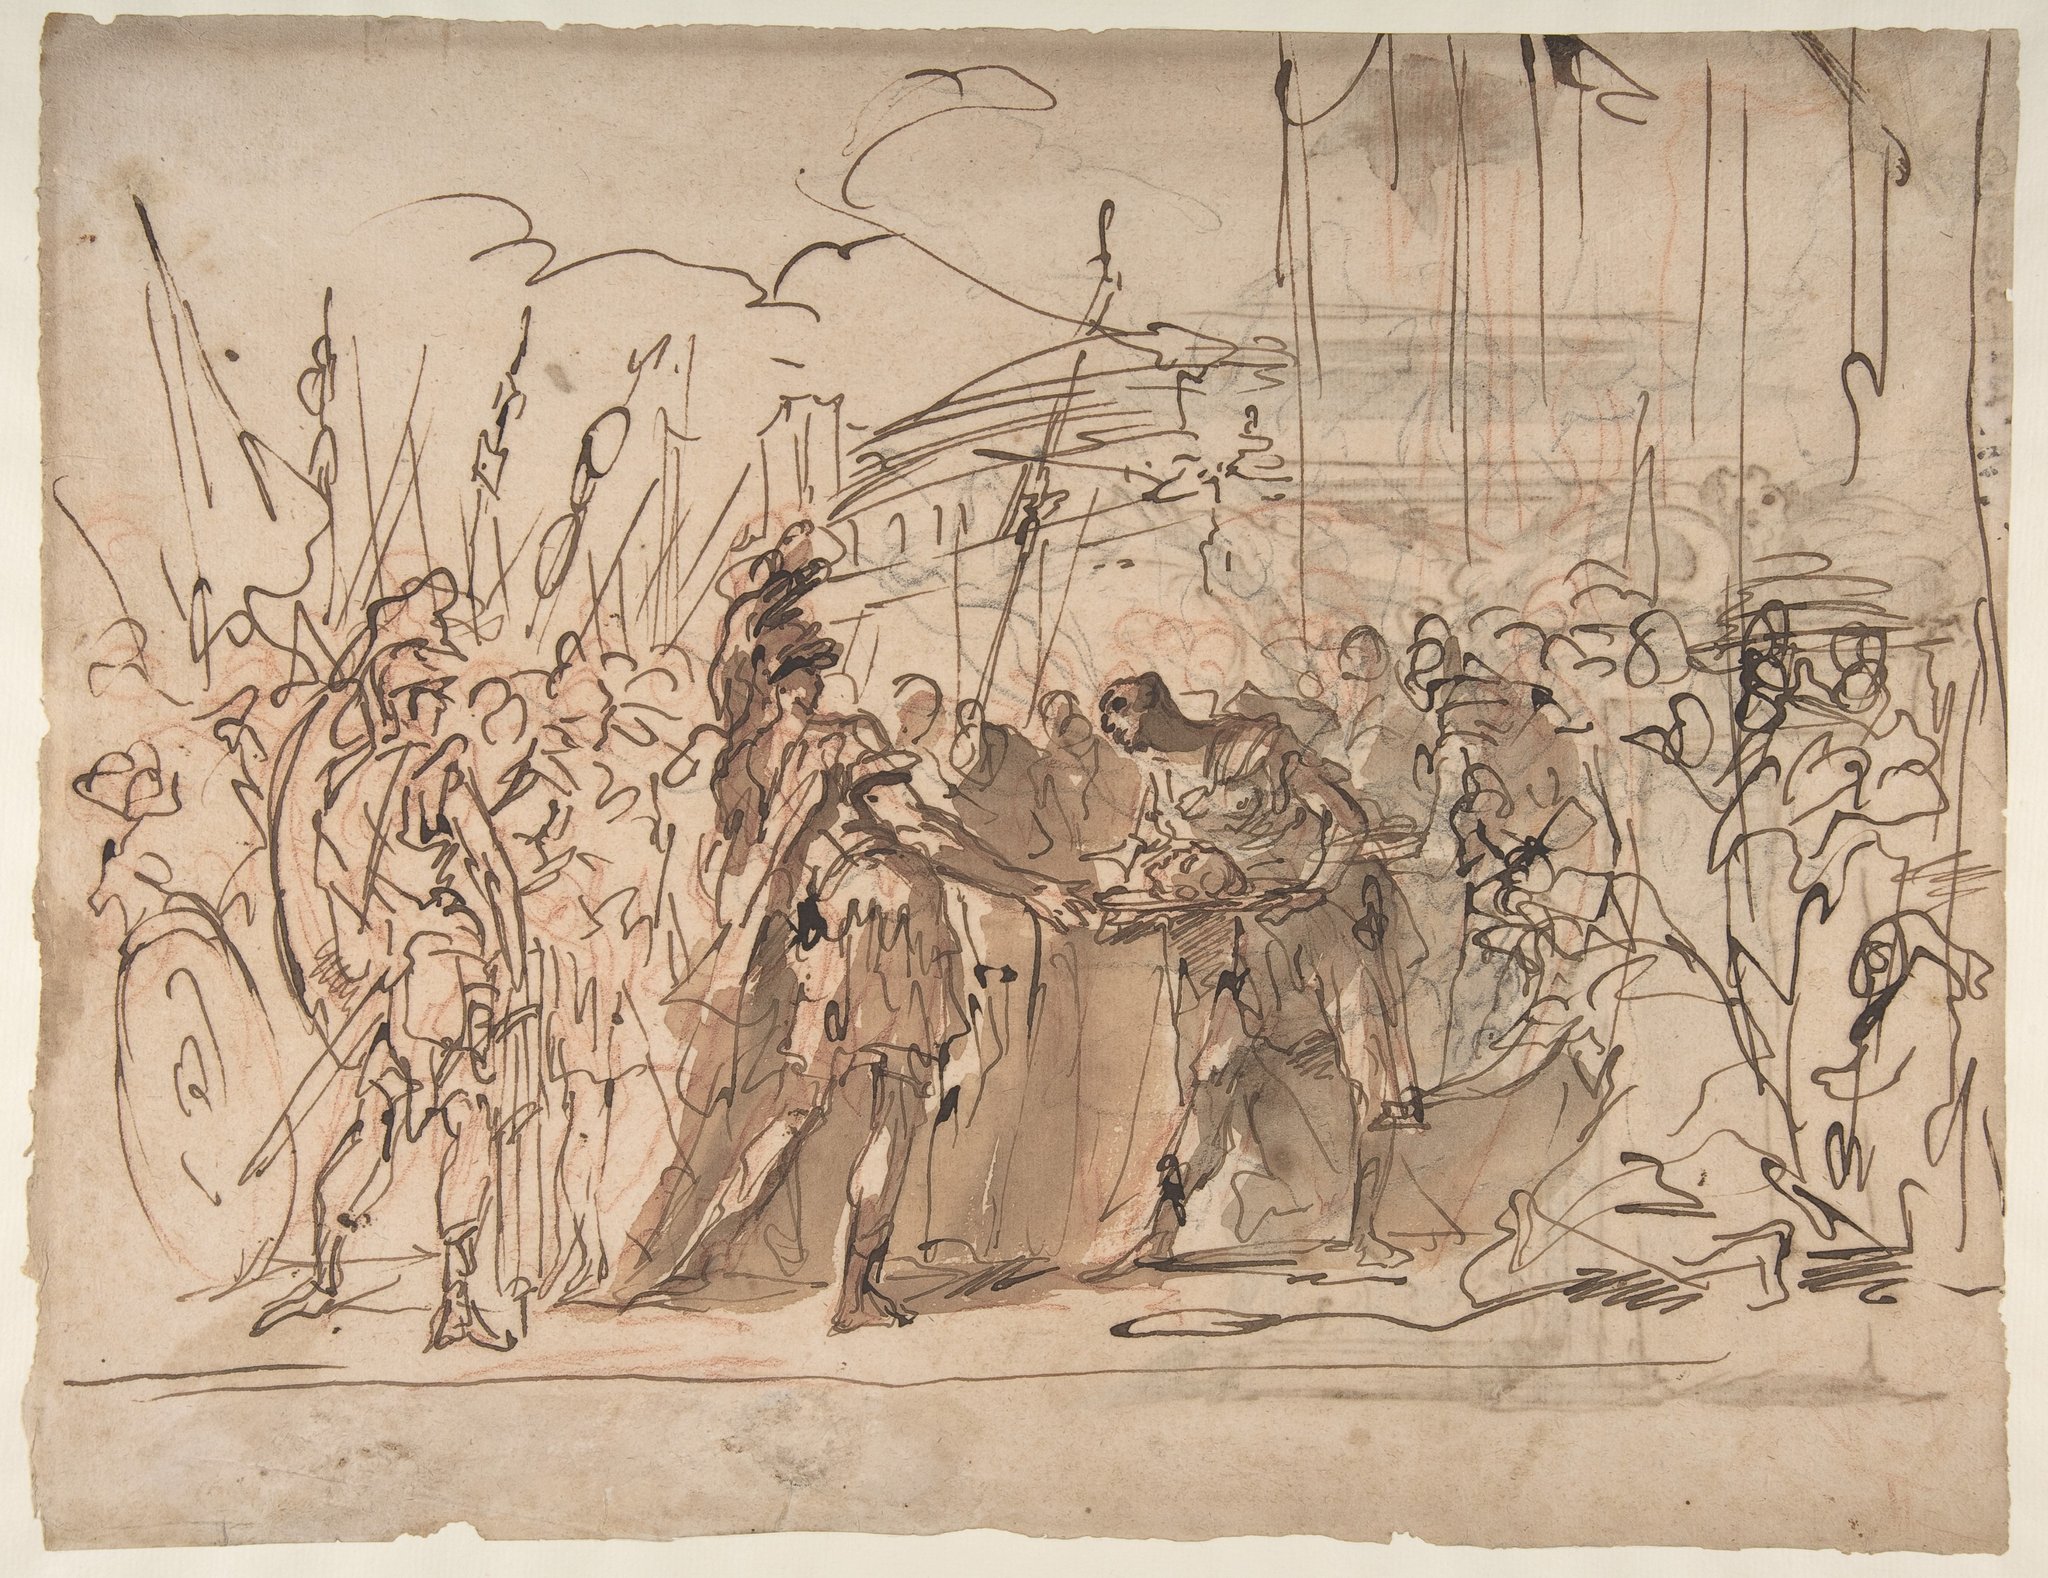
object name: drawing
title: The Head of Pompey Presented to Julius Caesar (recto); Study for an Elaborate Door Frame (verso)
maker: giovanni antonio pellegrini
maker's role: artist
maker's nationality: italian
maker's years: 1675-1741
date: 1675-1741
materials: chalk, ink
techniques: brush, pen, wash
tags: human figures,doors,julius caesar,heads